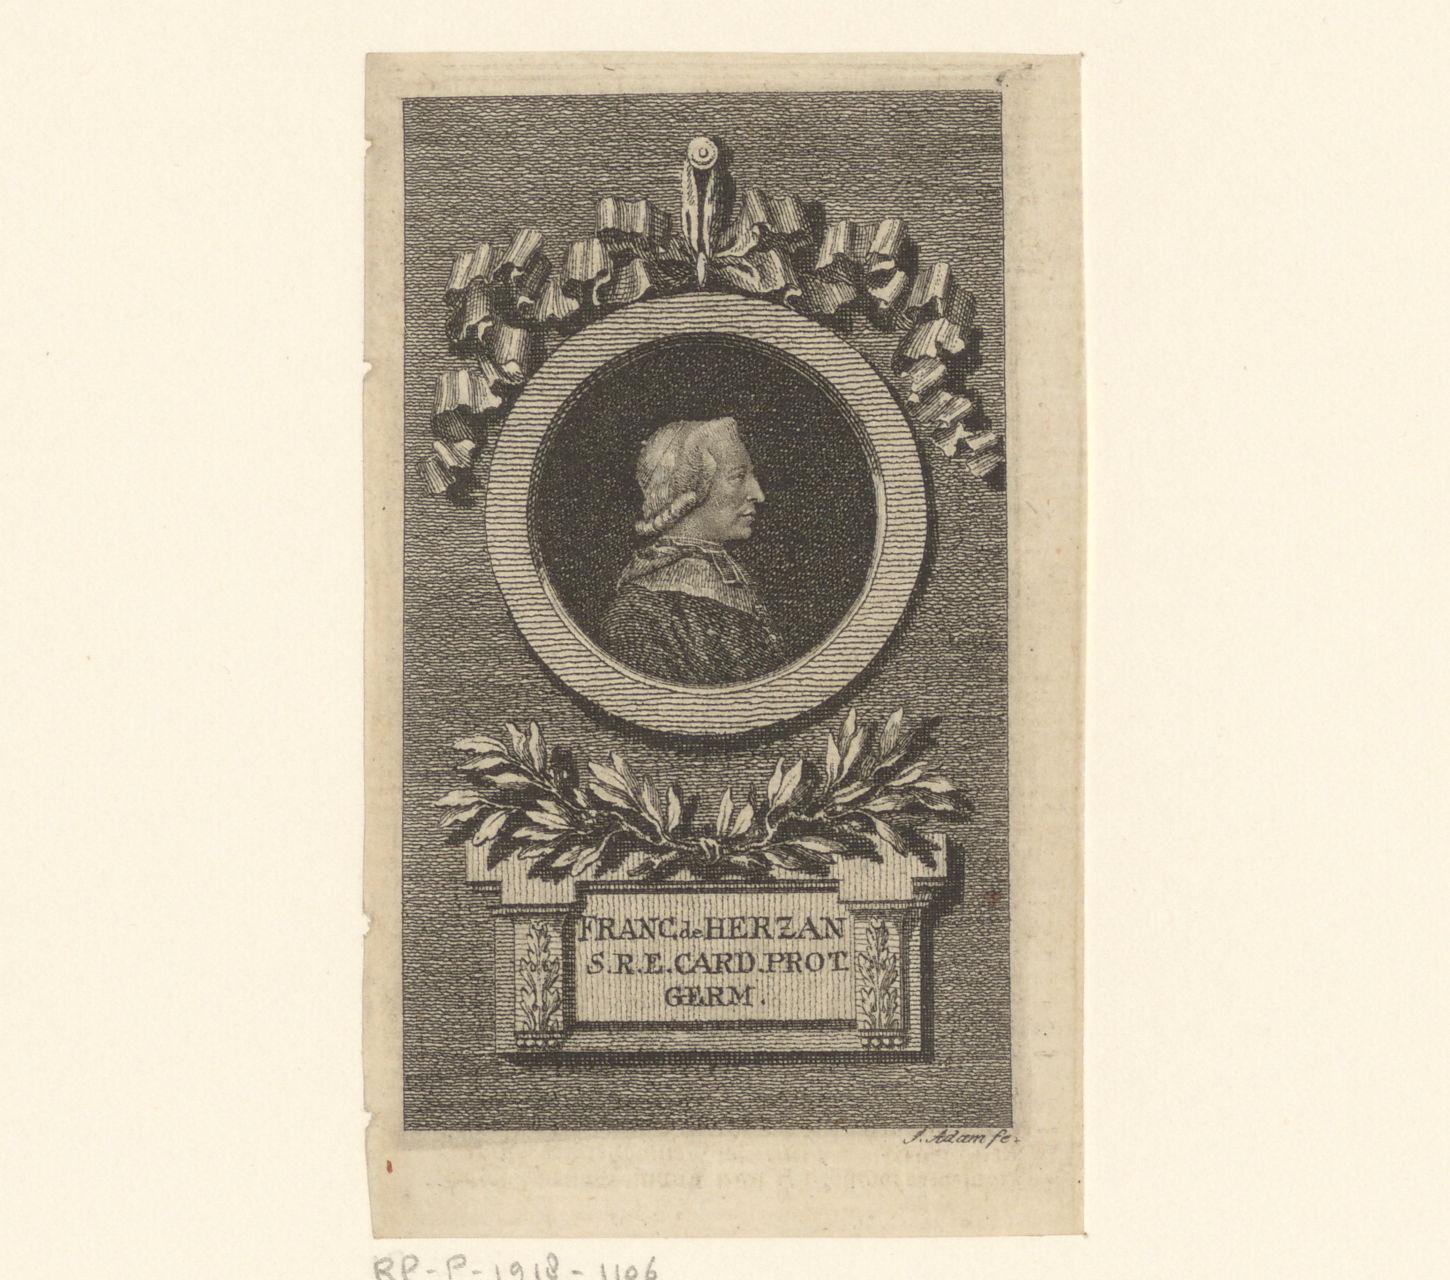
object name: print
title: Portret van František Herzan von Harras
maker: jakob adam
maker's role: print maker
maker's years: 1748-1811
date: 1758-1811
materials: paper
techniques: etching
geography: vienna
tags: vienna, historical persons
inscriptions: collector's mark: Lugt 2233